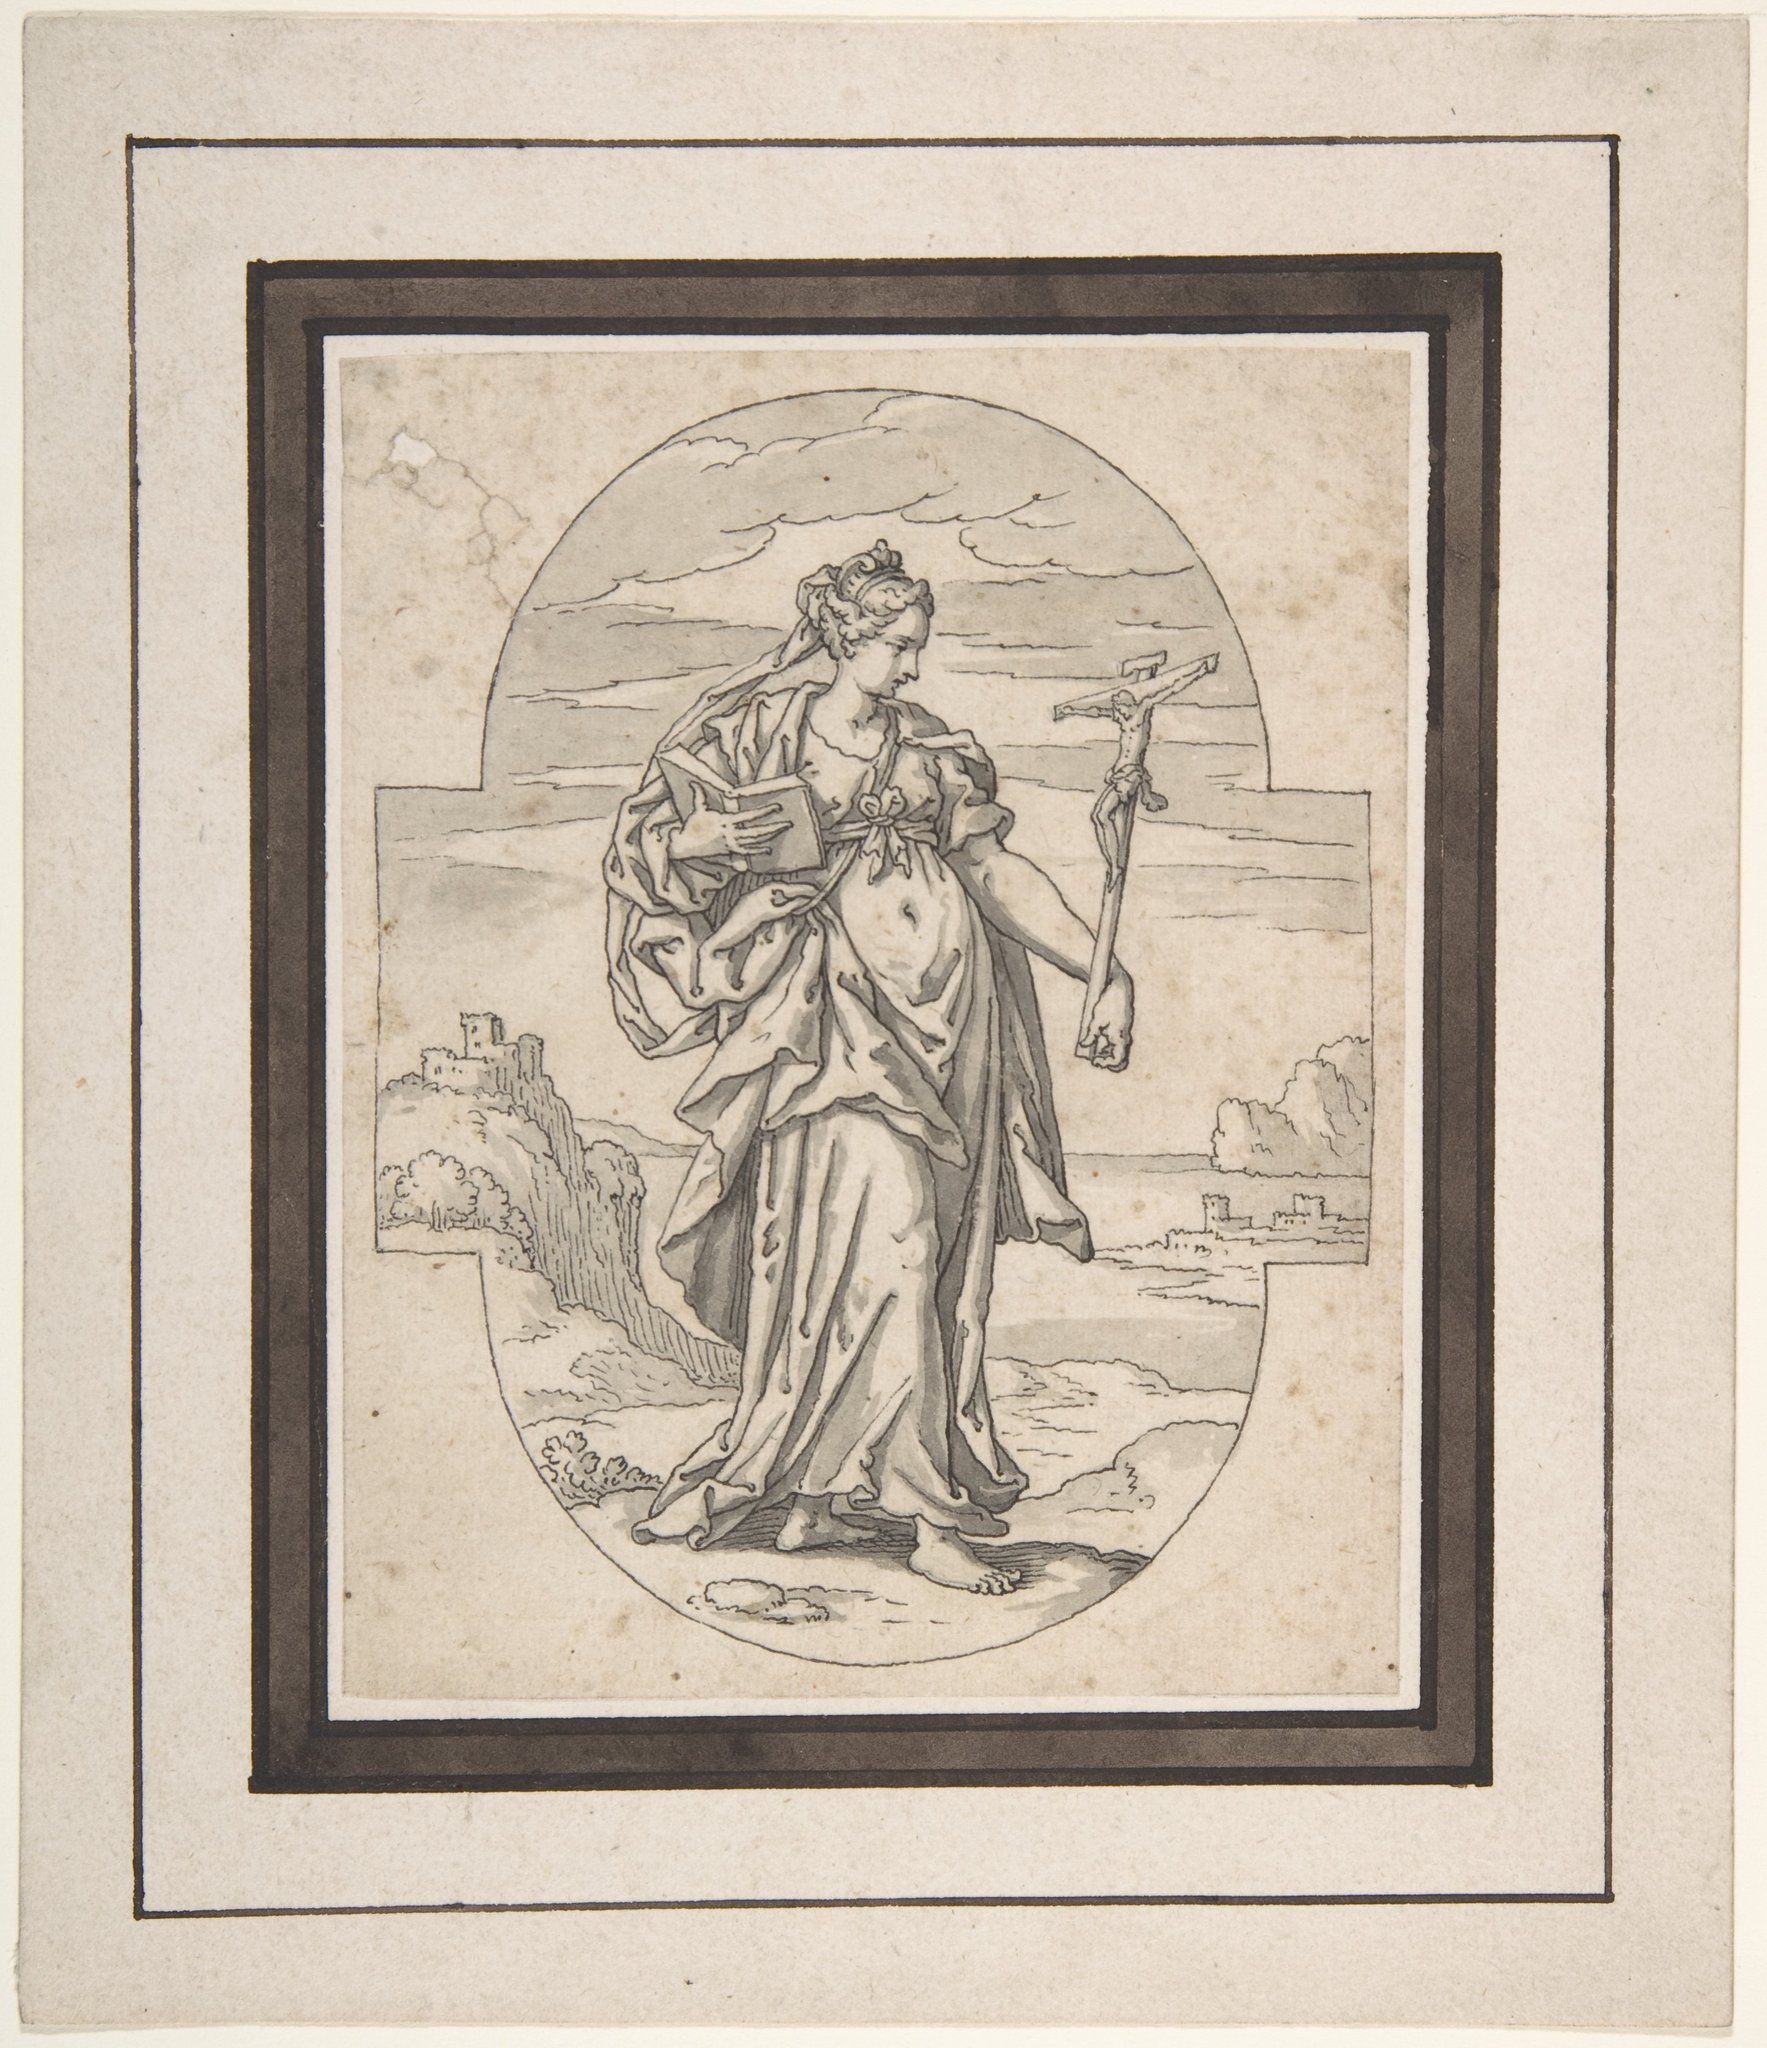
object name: drawing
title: Allegory of Faith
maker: hans friedrich schorer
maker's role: artist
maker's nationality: german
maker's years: 1609-1649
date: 1620-1649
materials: ink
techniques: pen, wash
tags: women,christ,cross